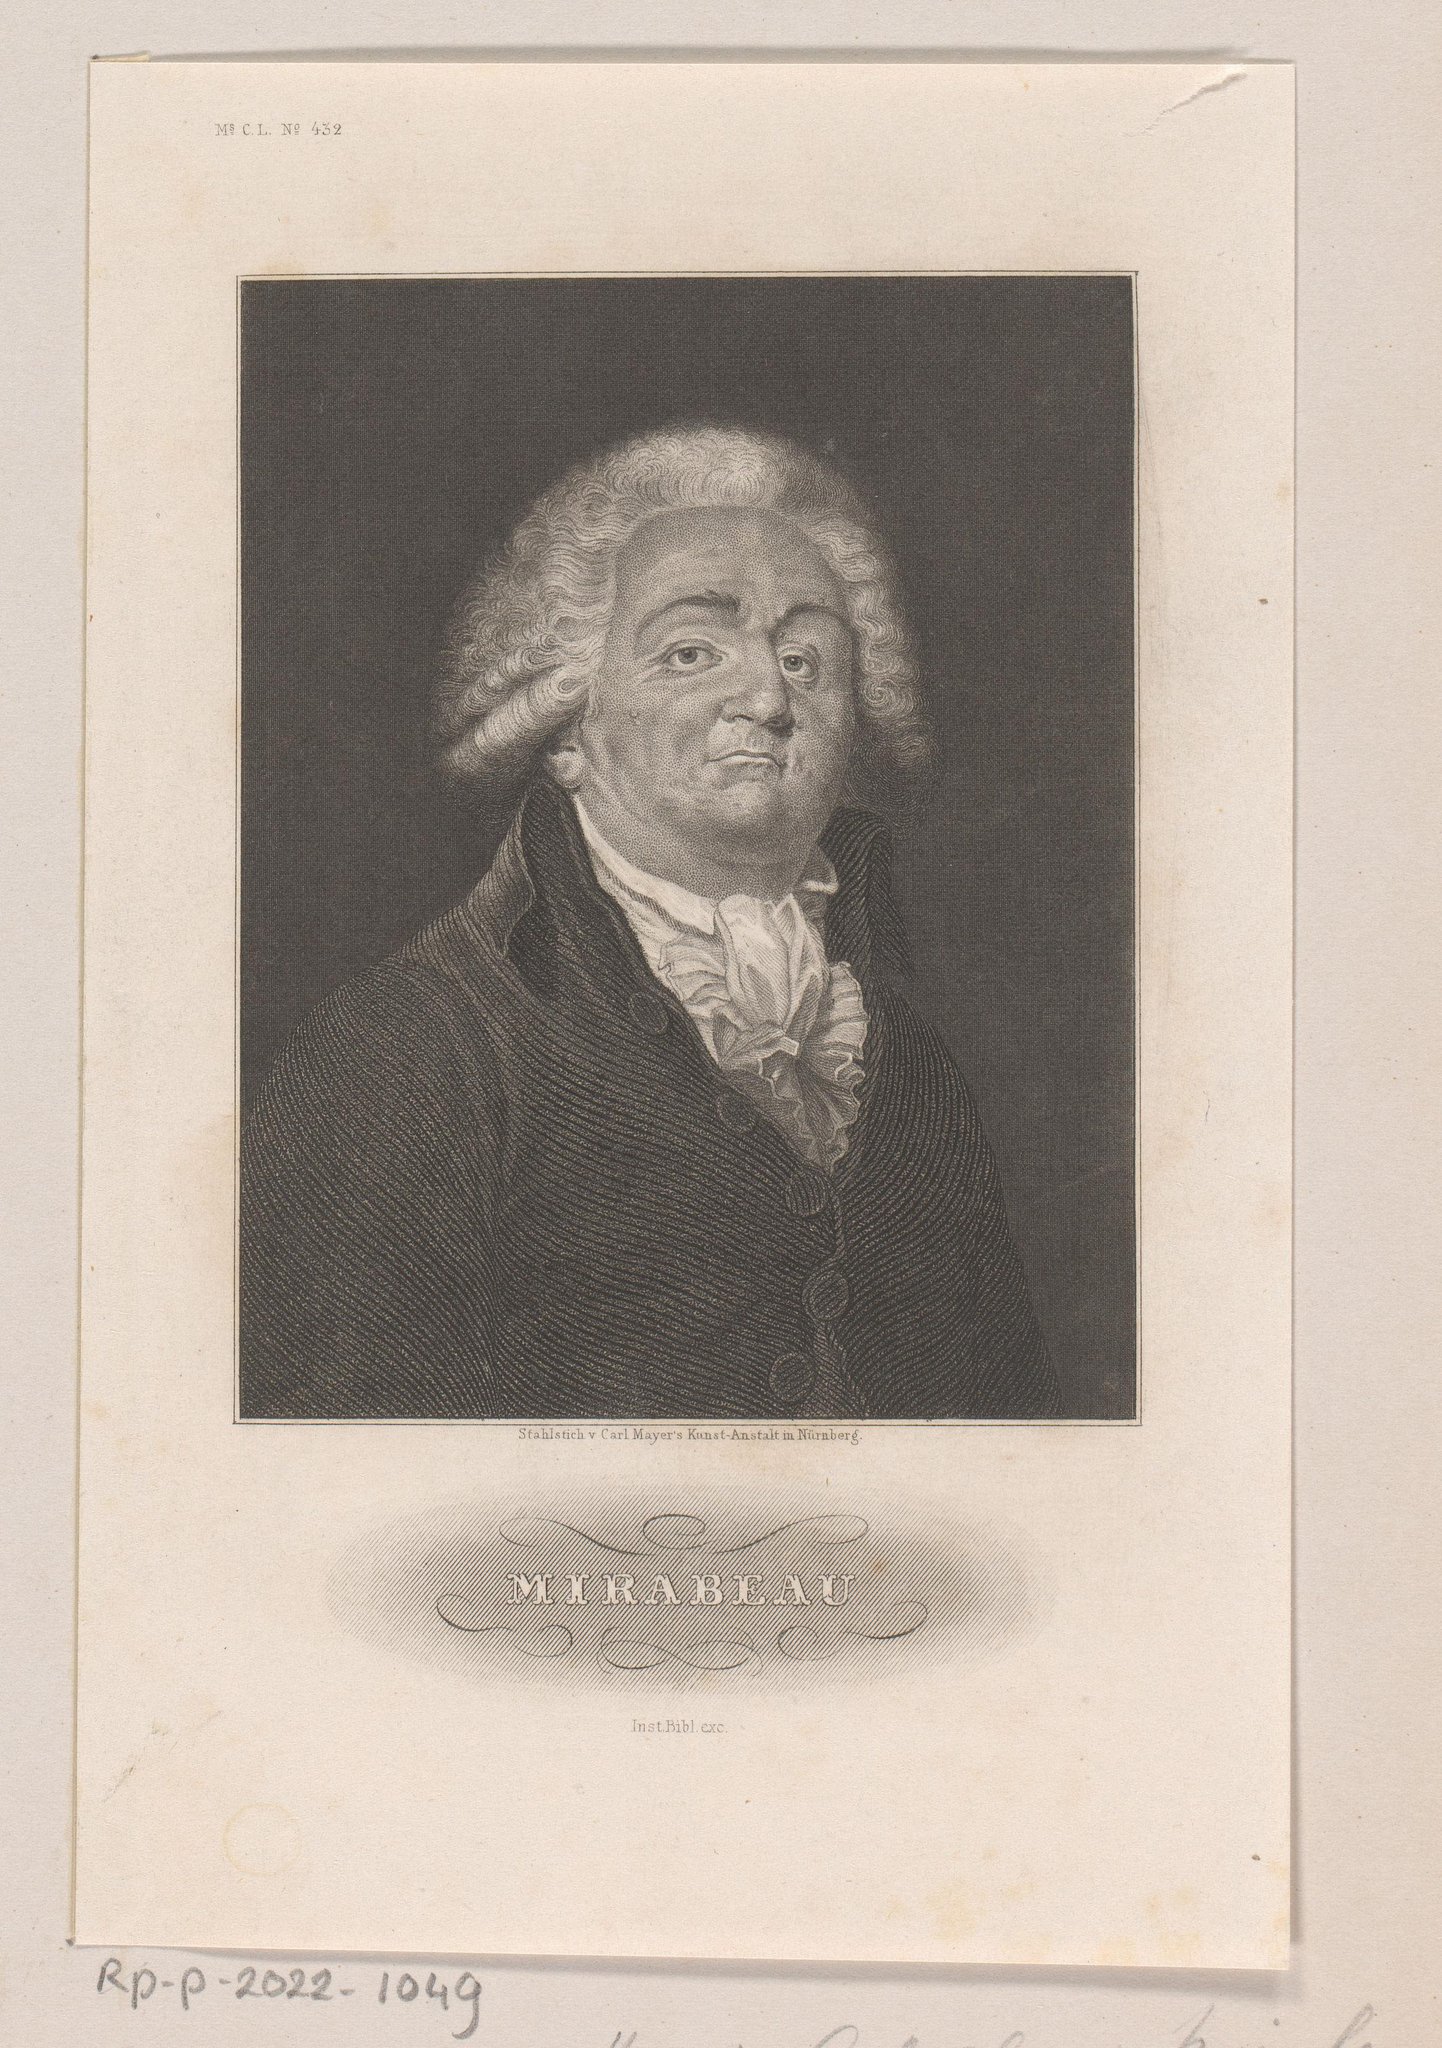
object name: print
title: Mirabeau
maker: carl mayer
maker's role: print maker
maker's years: 1798-1868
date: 1813-1868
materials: paper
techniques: engraving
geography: nuremberg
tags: paris, politician, honoré-gabriel de riqueti (graaf van mirabeau), historical persons, ambassador